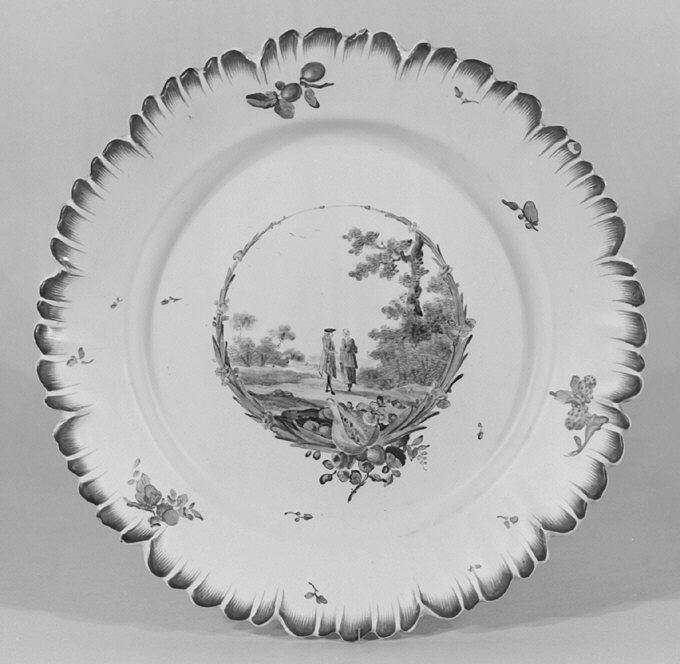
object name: plate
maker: fidelle duvivier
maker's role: decorator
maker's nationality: french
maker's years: 1740-1796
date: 1753-1795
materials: faience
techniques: glazing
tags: men,women,trees